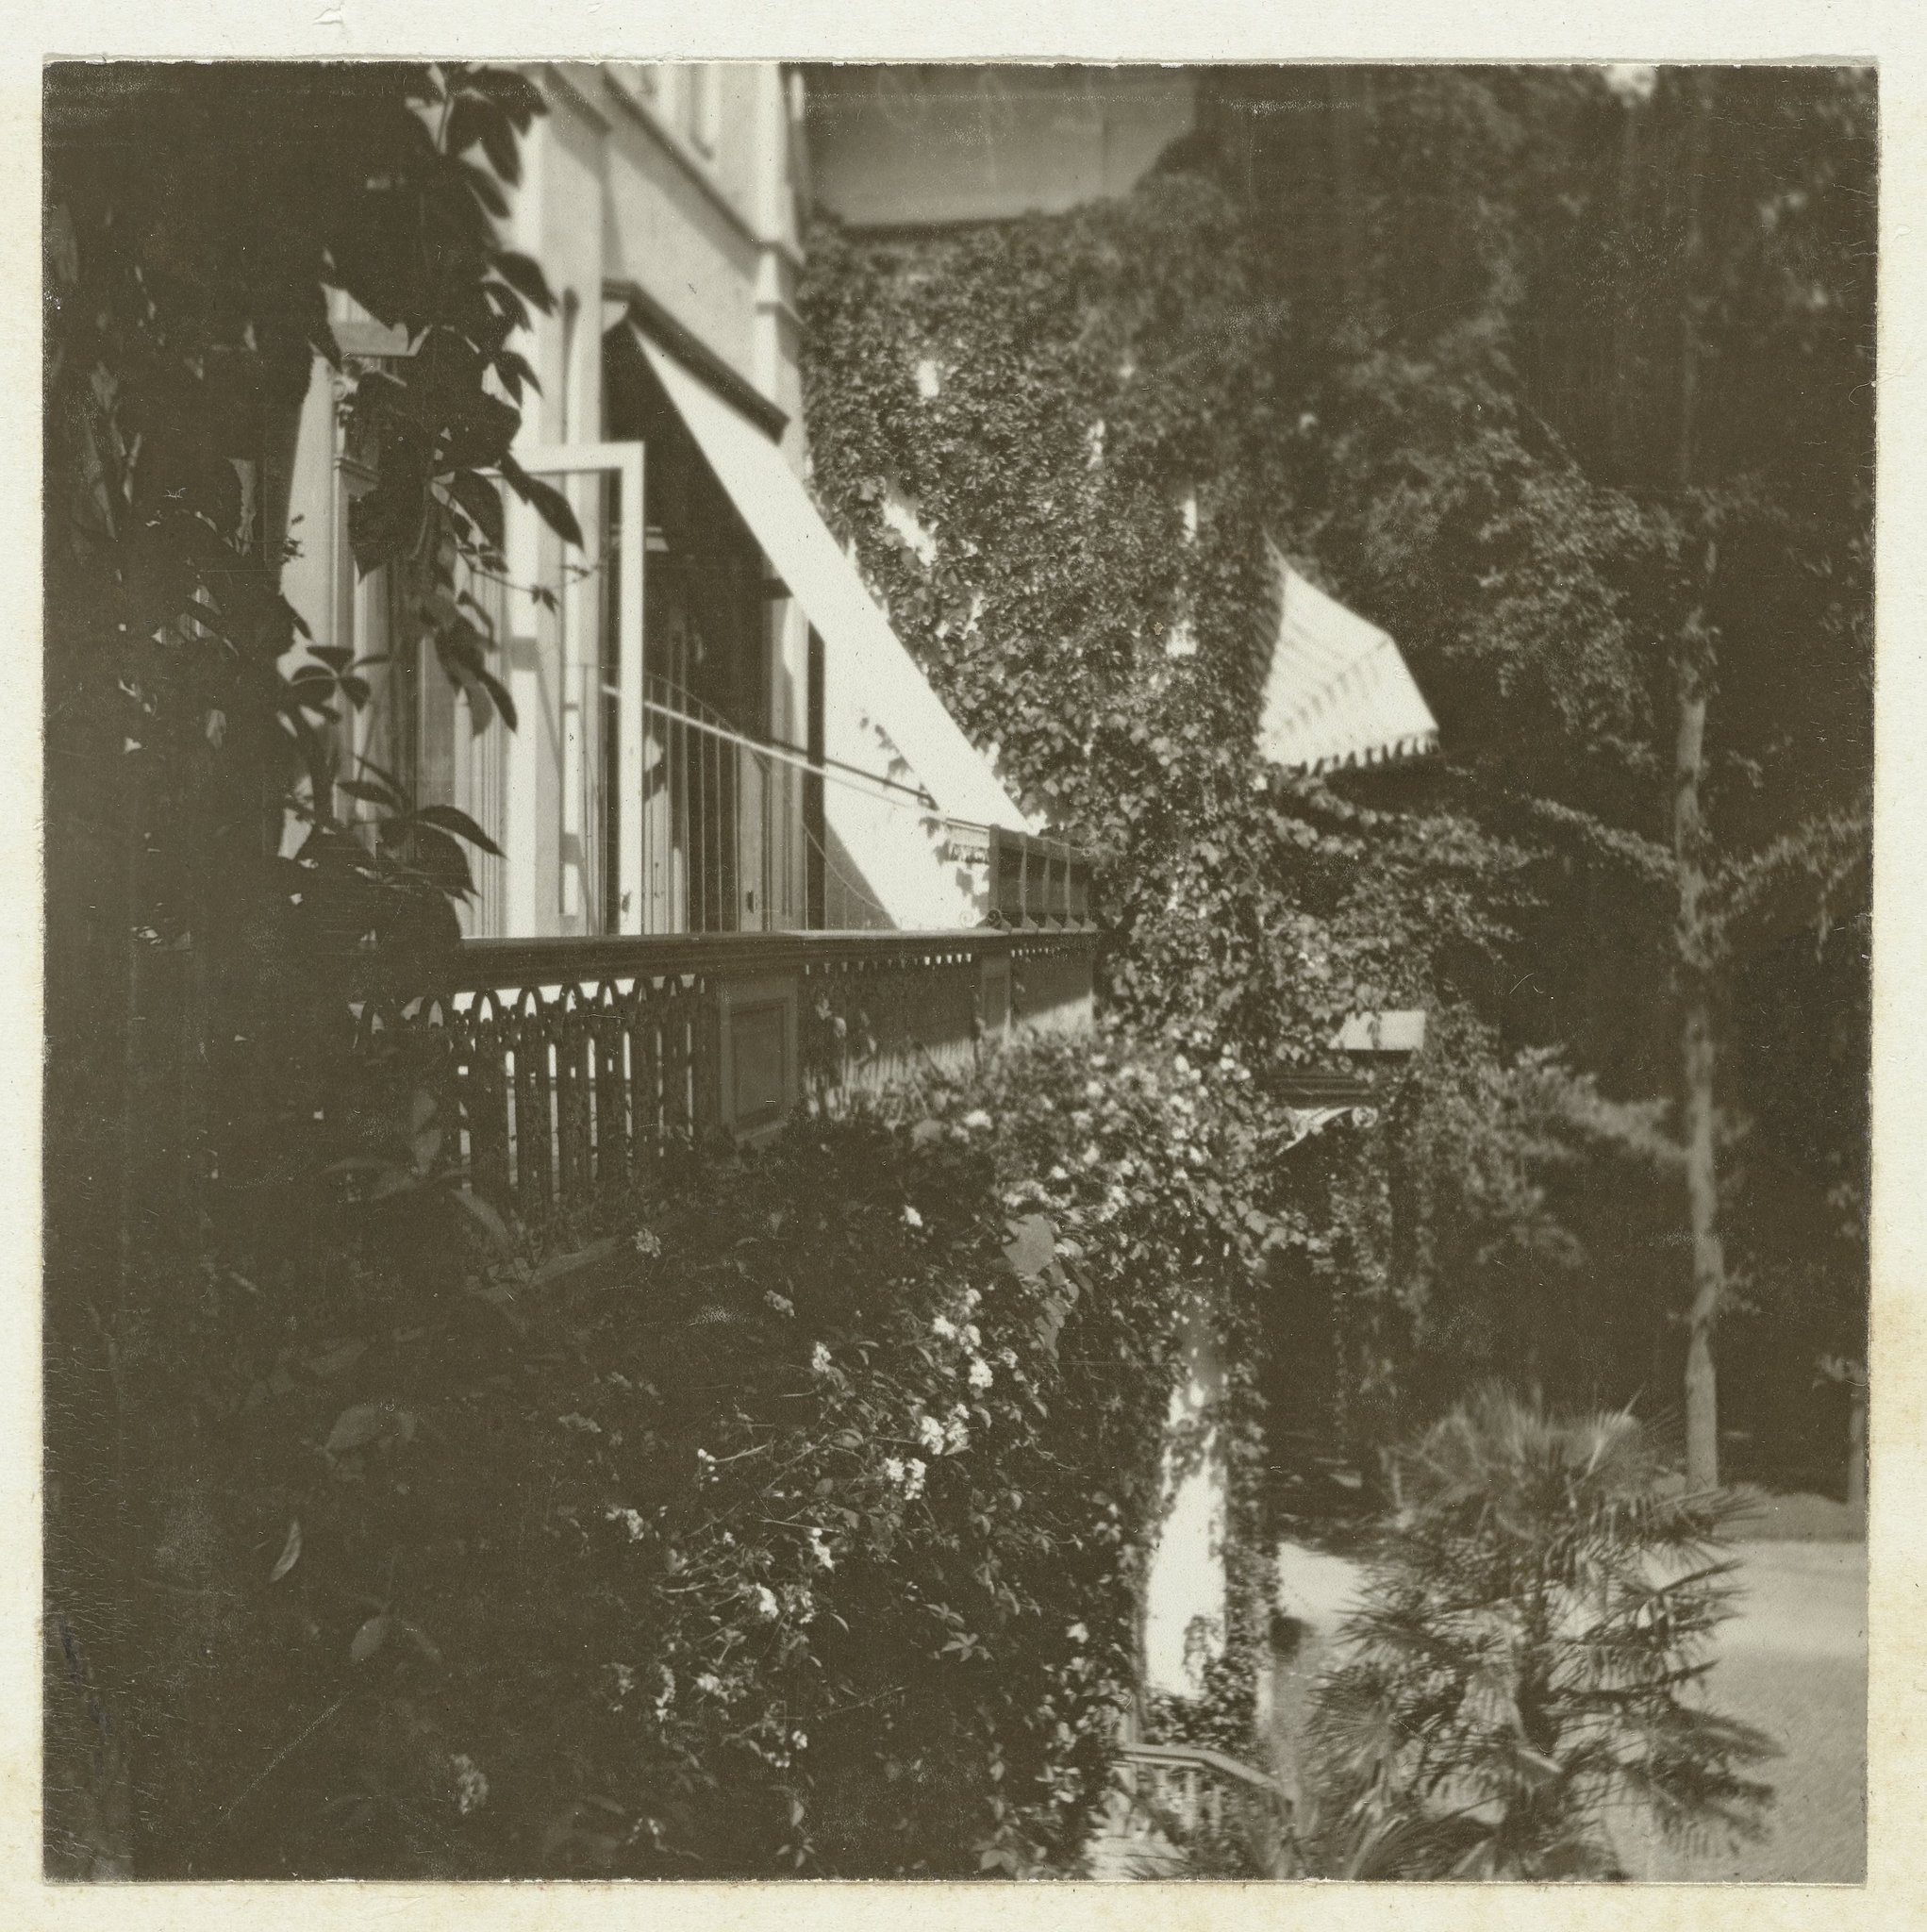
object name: photograph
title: Balkon van landhuis De Wildbaan, Driebergen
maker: henry pauw van wieldrecht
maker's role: fotograaf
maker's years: 1863-1912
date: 1903-1907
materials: paper, photographic support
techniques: gelatin silver print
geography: netherlands